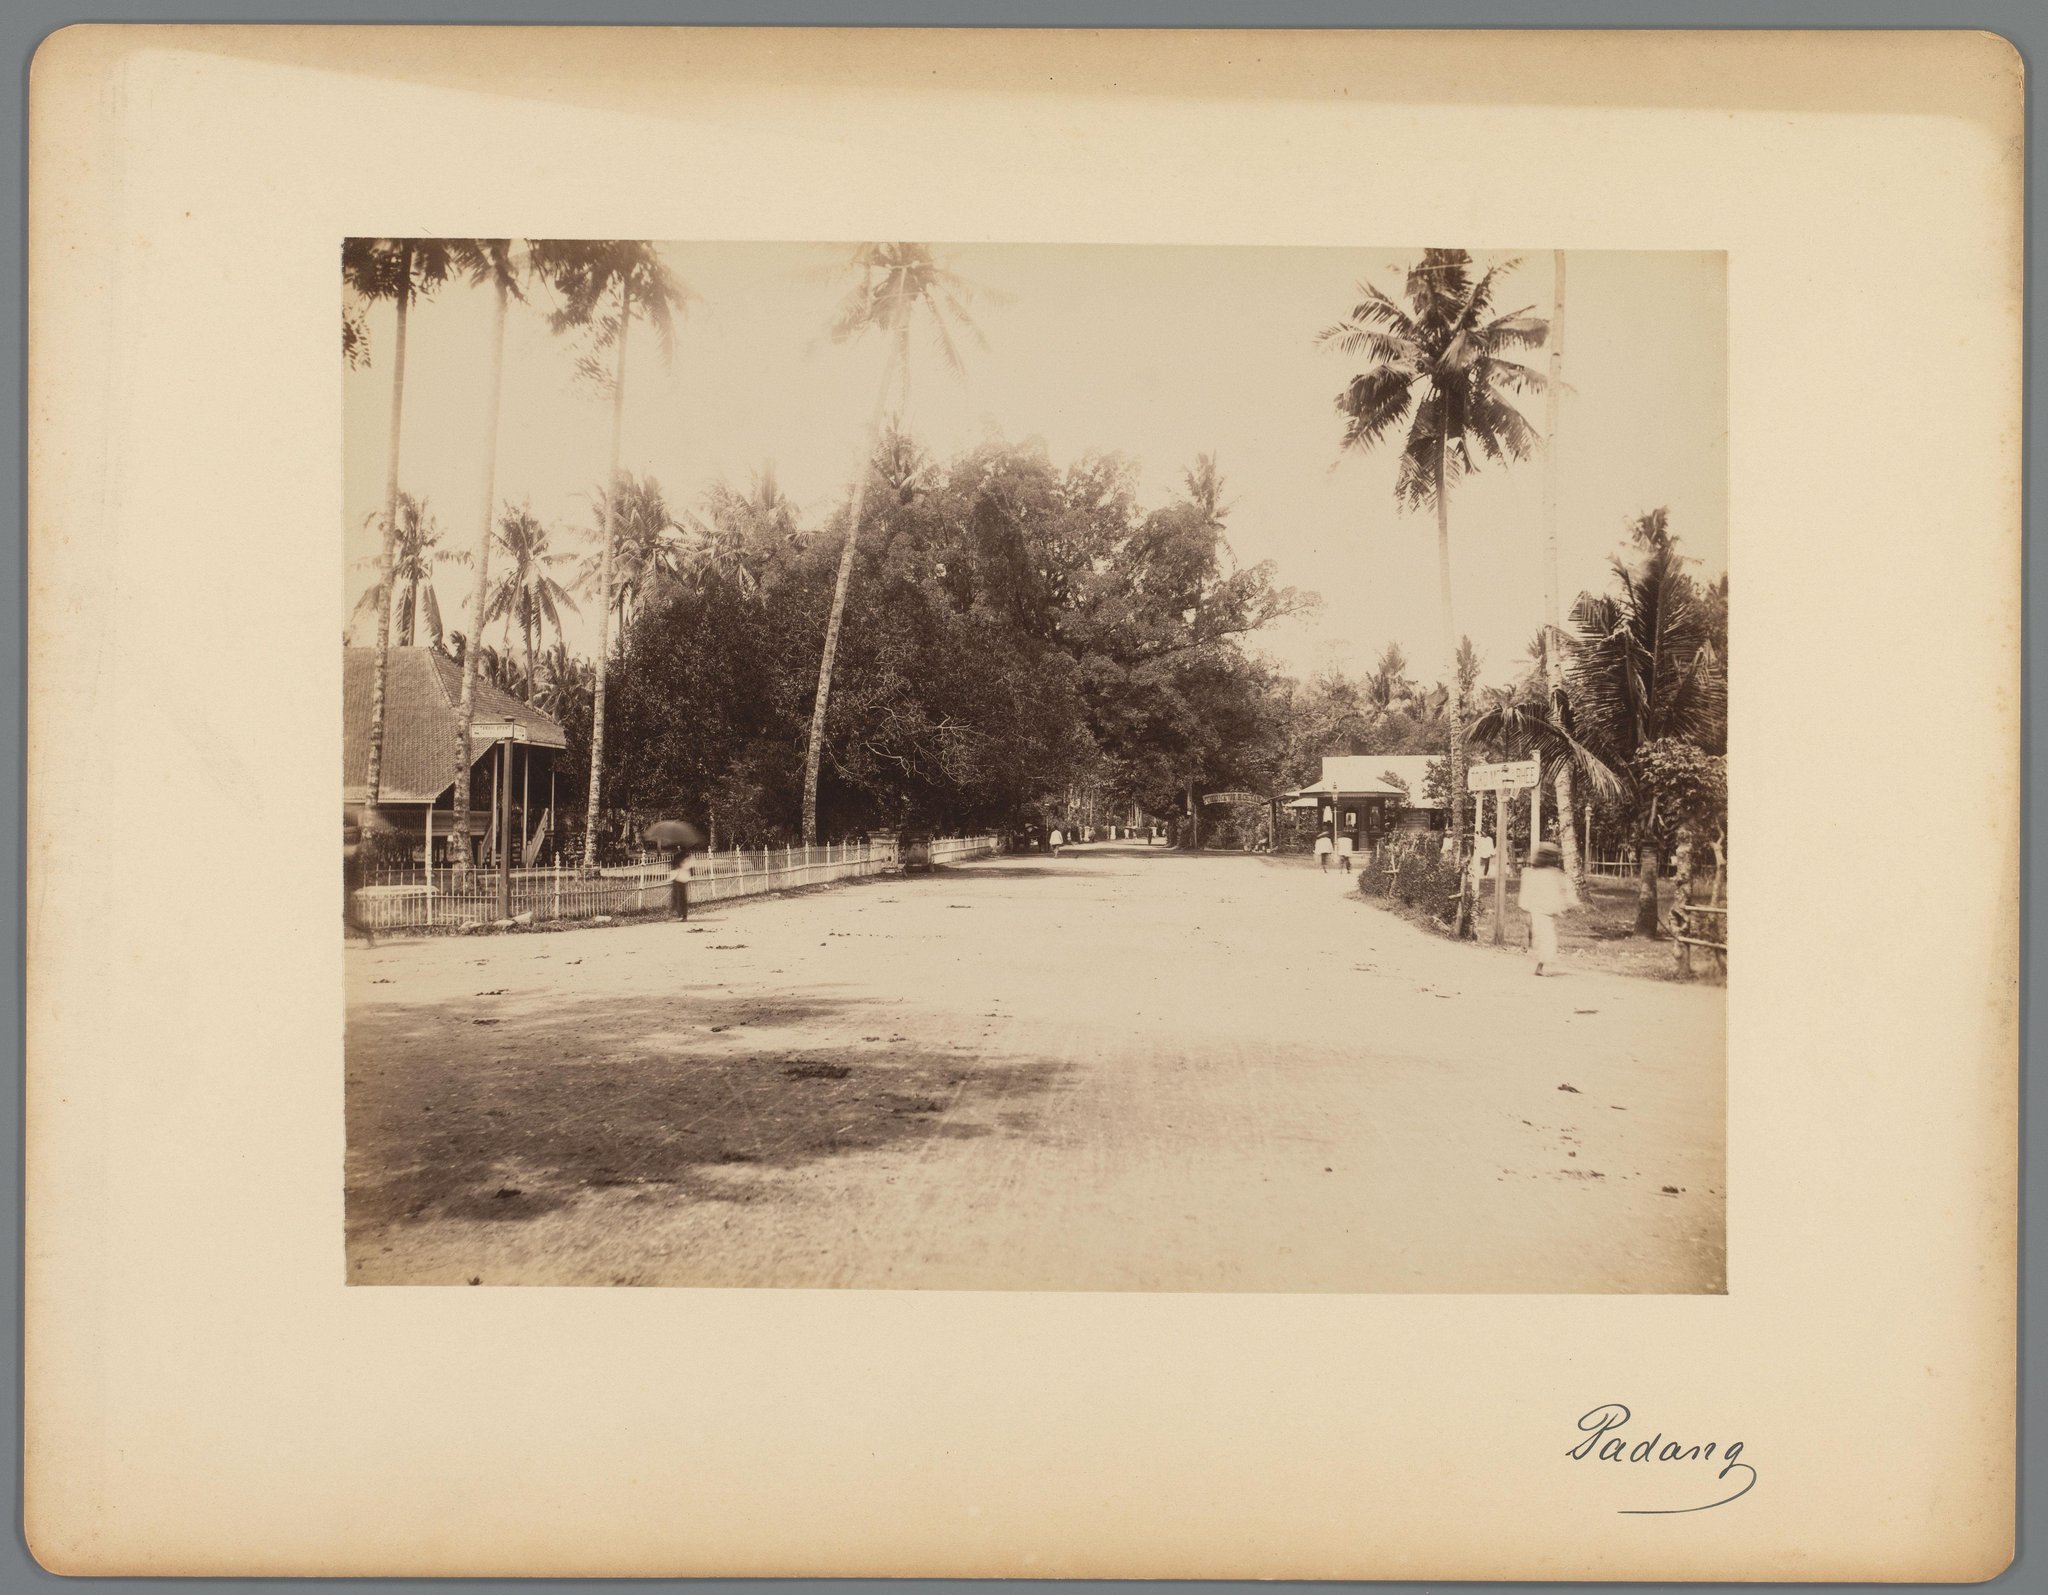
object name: photograph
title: Straatgezicht in Padang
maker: christiaan benjamin nieuwenhuis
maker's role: publisher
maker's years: 1863-1922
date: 1891-1905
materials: cardboard, paper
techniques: albumen print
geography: padang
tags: trees: palm-tree, street (+ city(-scape) with figures, staffage)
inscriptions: inscription: ‘FOTO’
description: Deze foto zat oorspronkelijk in prentenkabinet RP-F-AA3192.